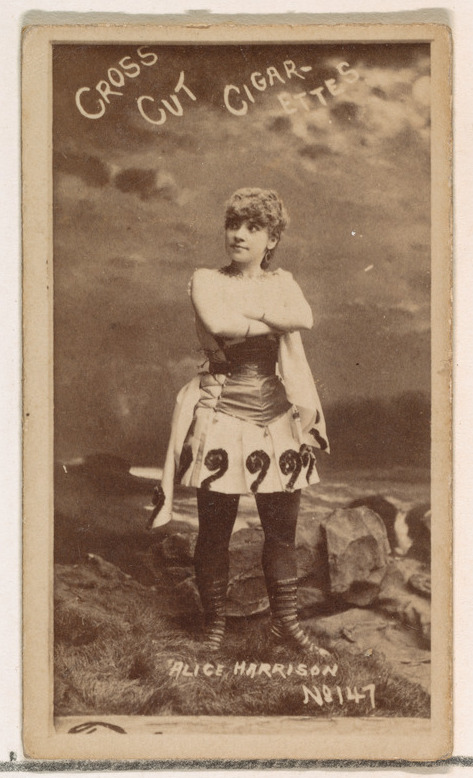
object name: print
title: Card Number 147, Alice Harrison, from the Actors and Actresses series (N145-1) issued by Duke Sons & Co. to promote Cross Cut Cigarettes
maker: w. duke, sons & co.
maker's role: publisher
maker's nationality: american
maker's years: 1870-1920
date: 1880-1889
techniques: albumen silver print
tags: portraits,women,actresses